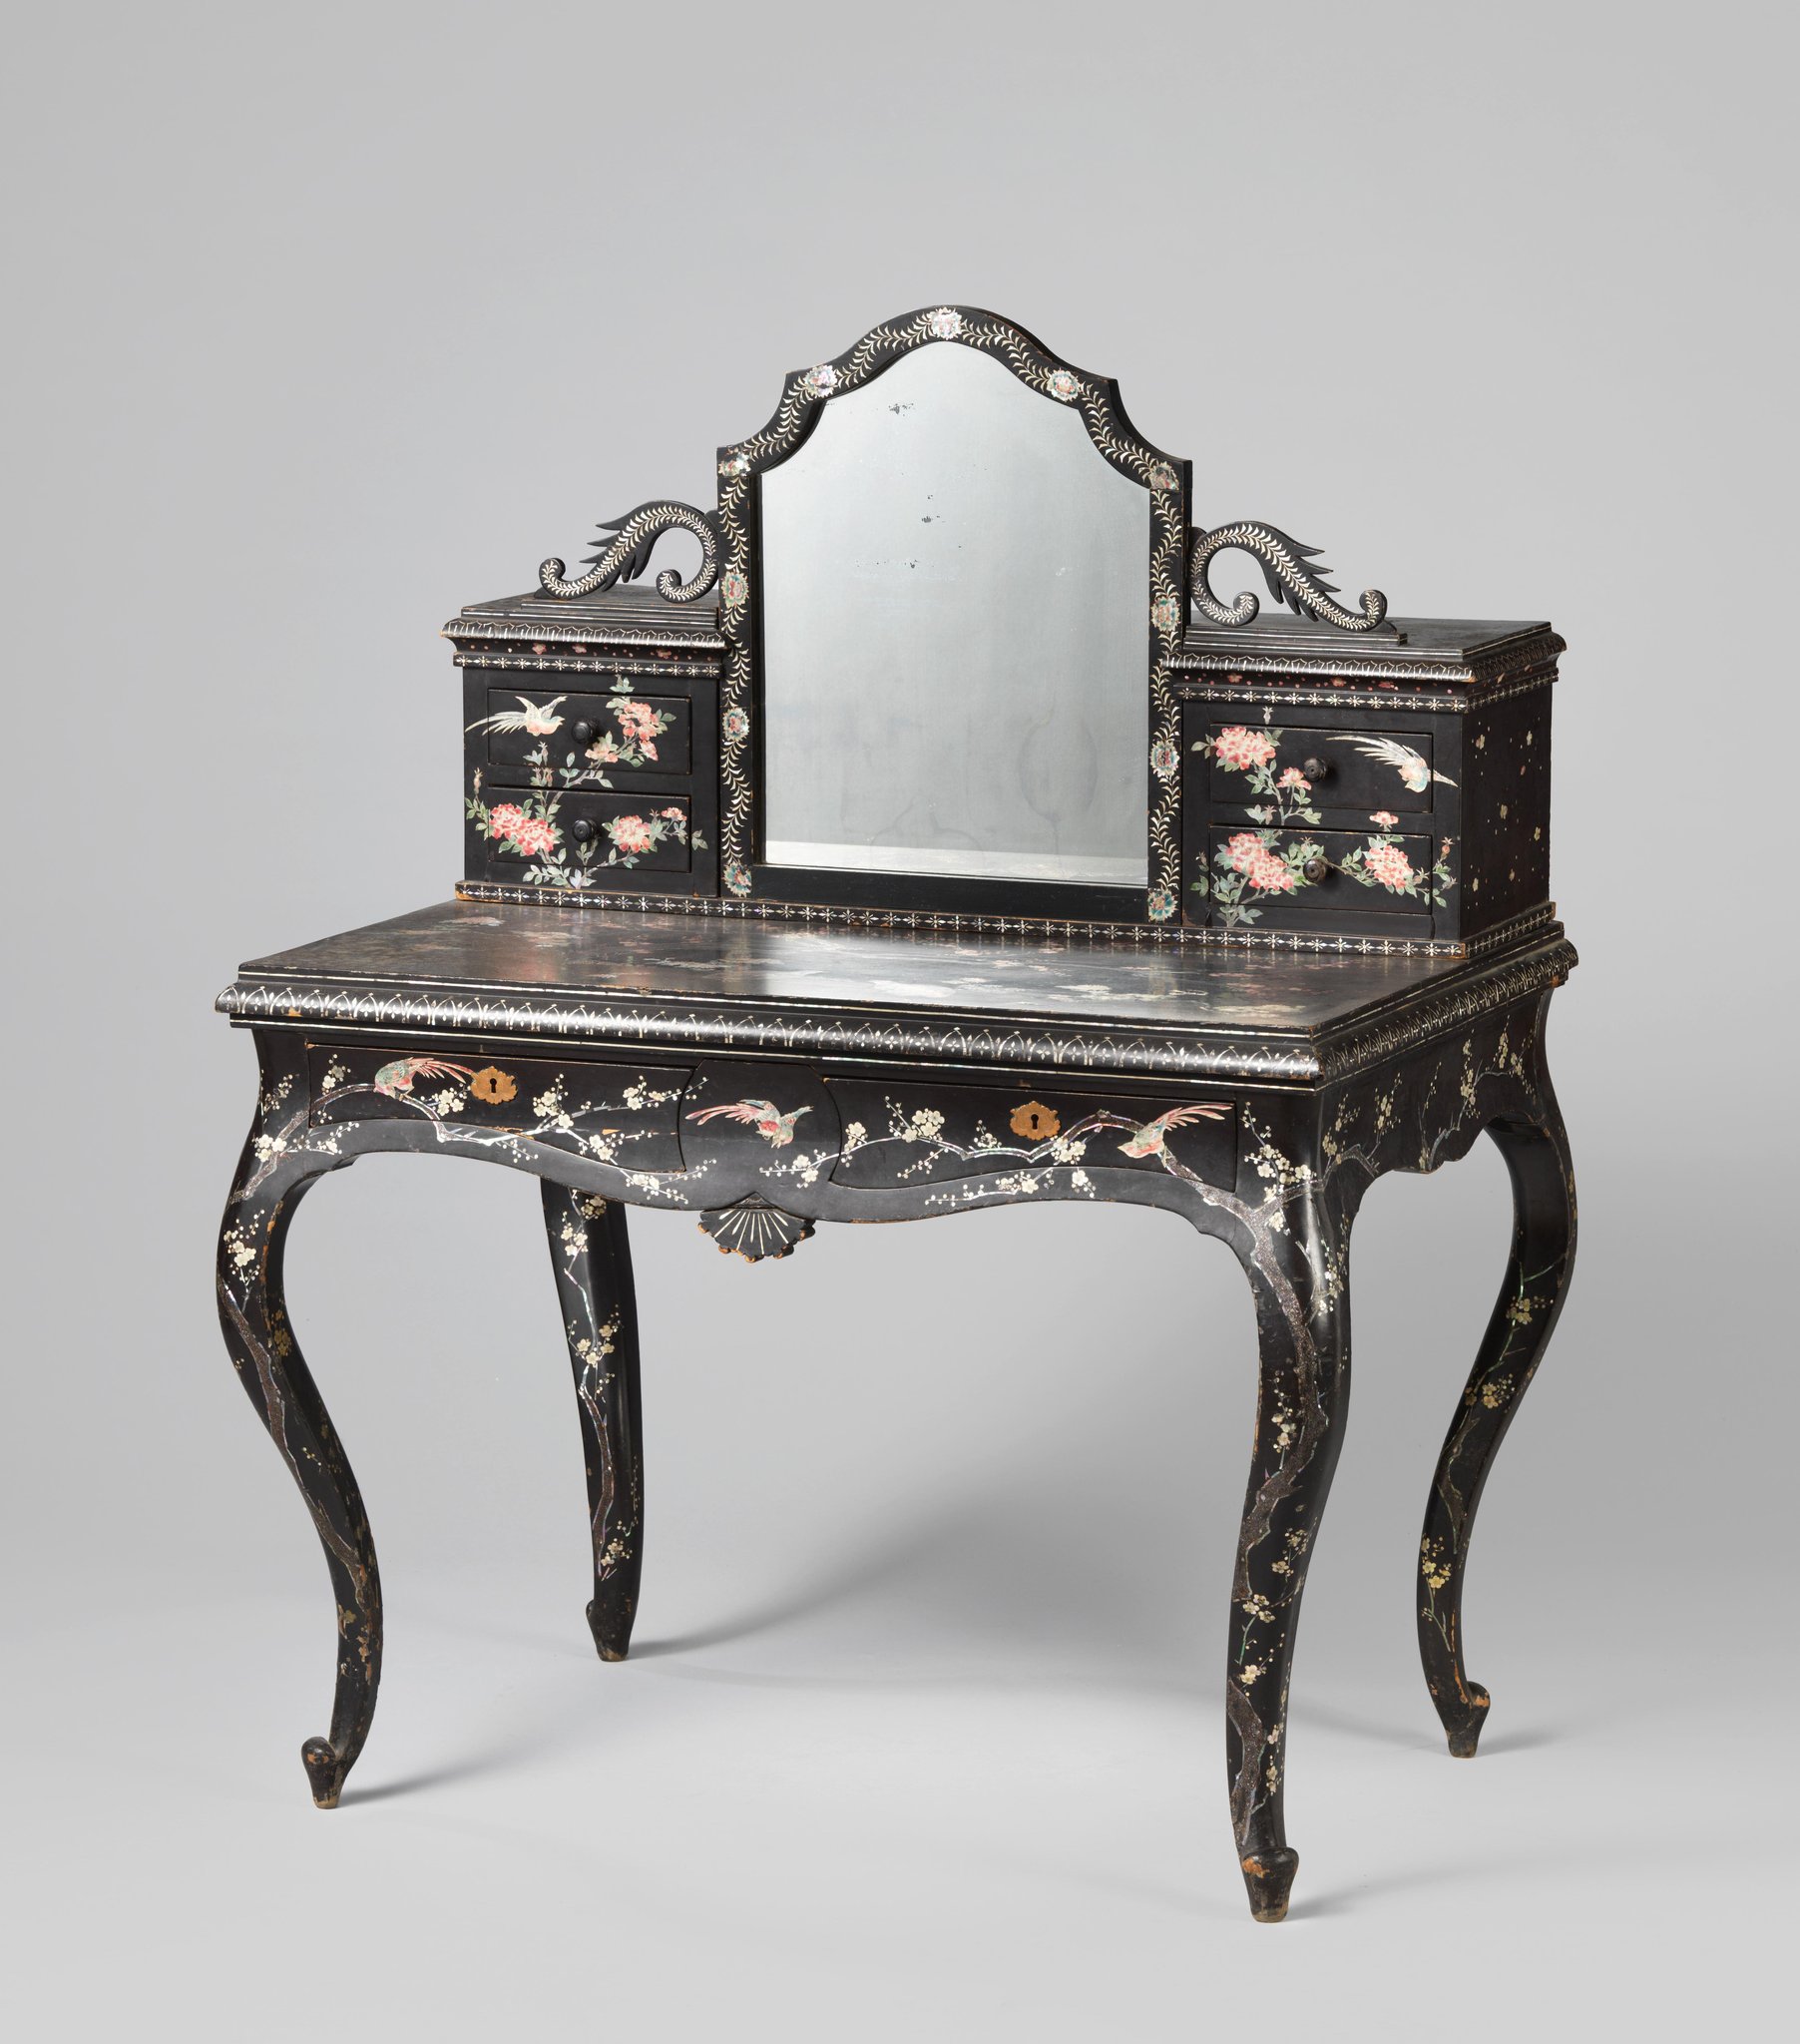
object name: table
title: Toilettafel van zwart lak met bloemtakken en vogels van ingelegd parelmoer.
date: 1850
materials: brass, glass, wood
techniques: intarsia, lacquer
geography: japan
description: Toilettafel versierd met zwart lak ingelegd met parelmoer, rustend op vier S-vormige gebogen poten. Op het blad is een opzetstuk aangebracht met een spiegel in het midden en twee boven elkaar geplaatste laden aan weerszijden. Het inlegwerk in parelmoer vertoont bloemtakken en vogels. Onder het blad twee laden.